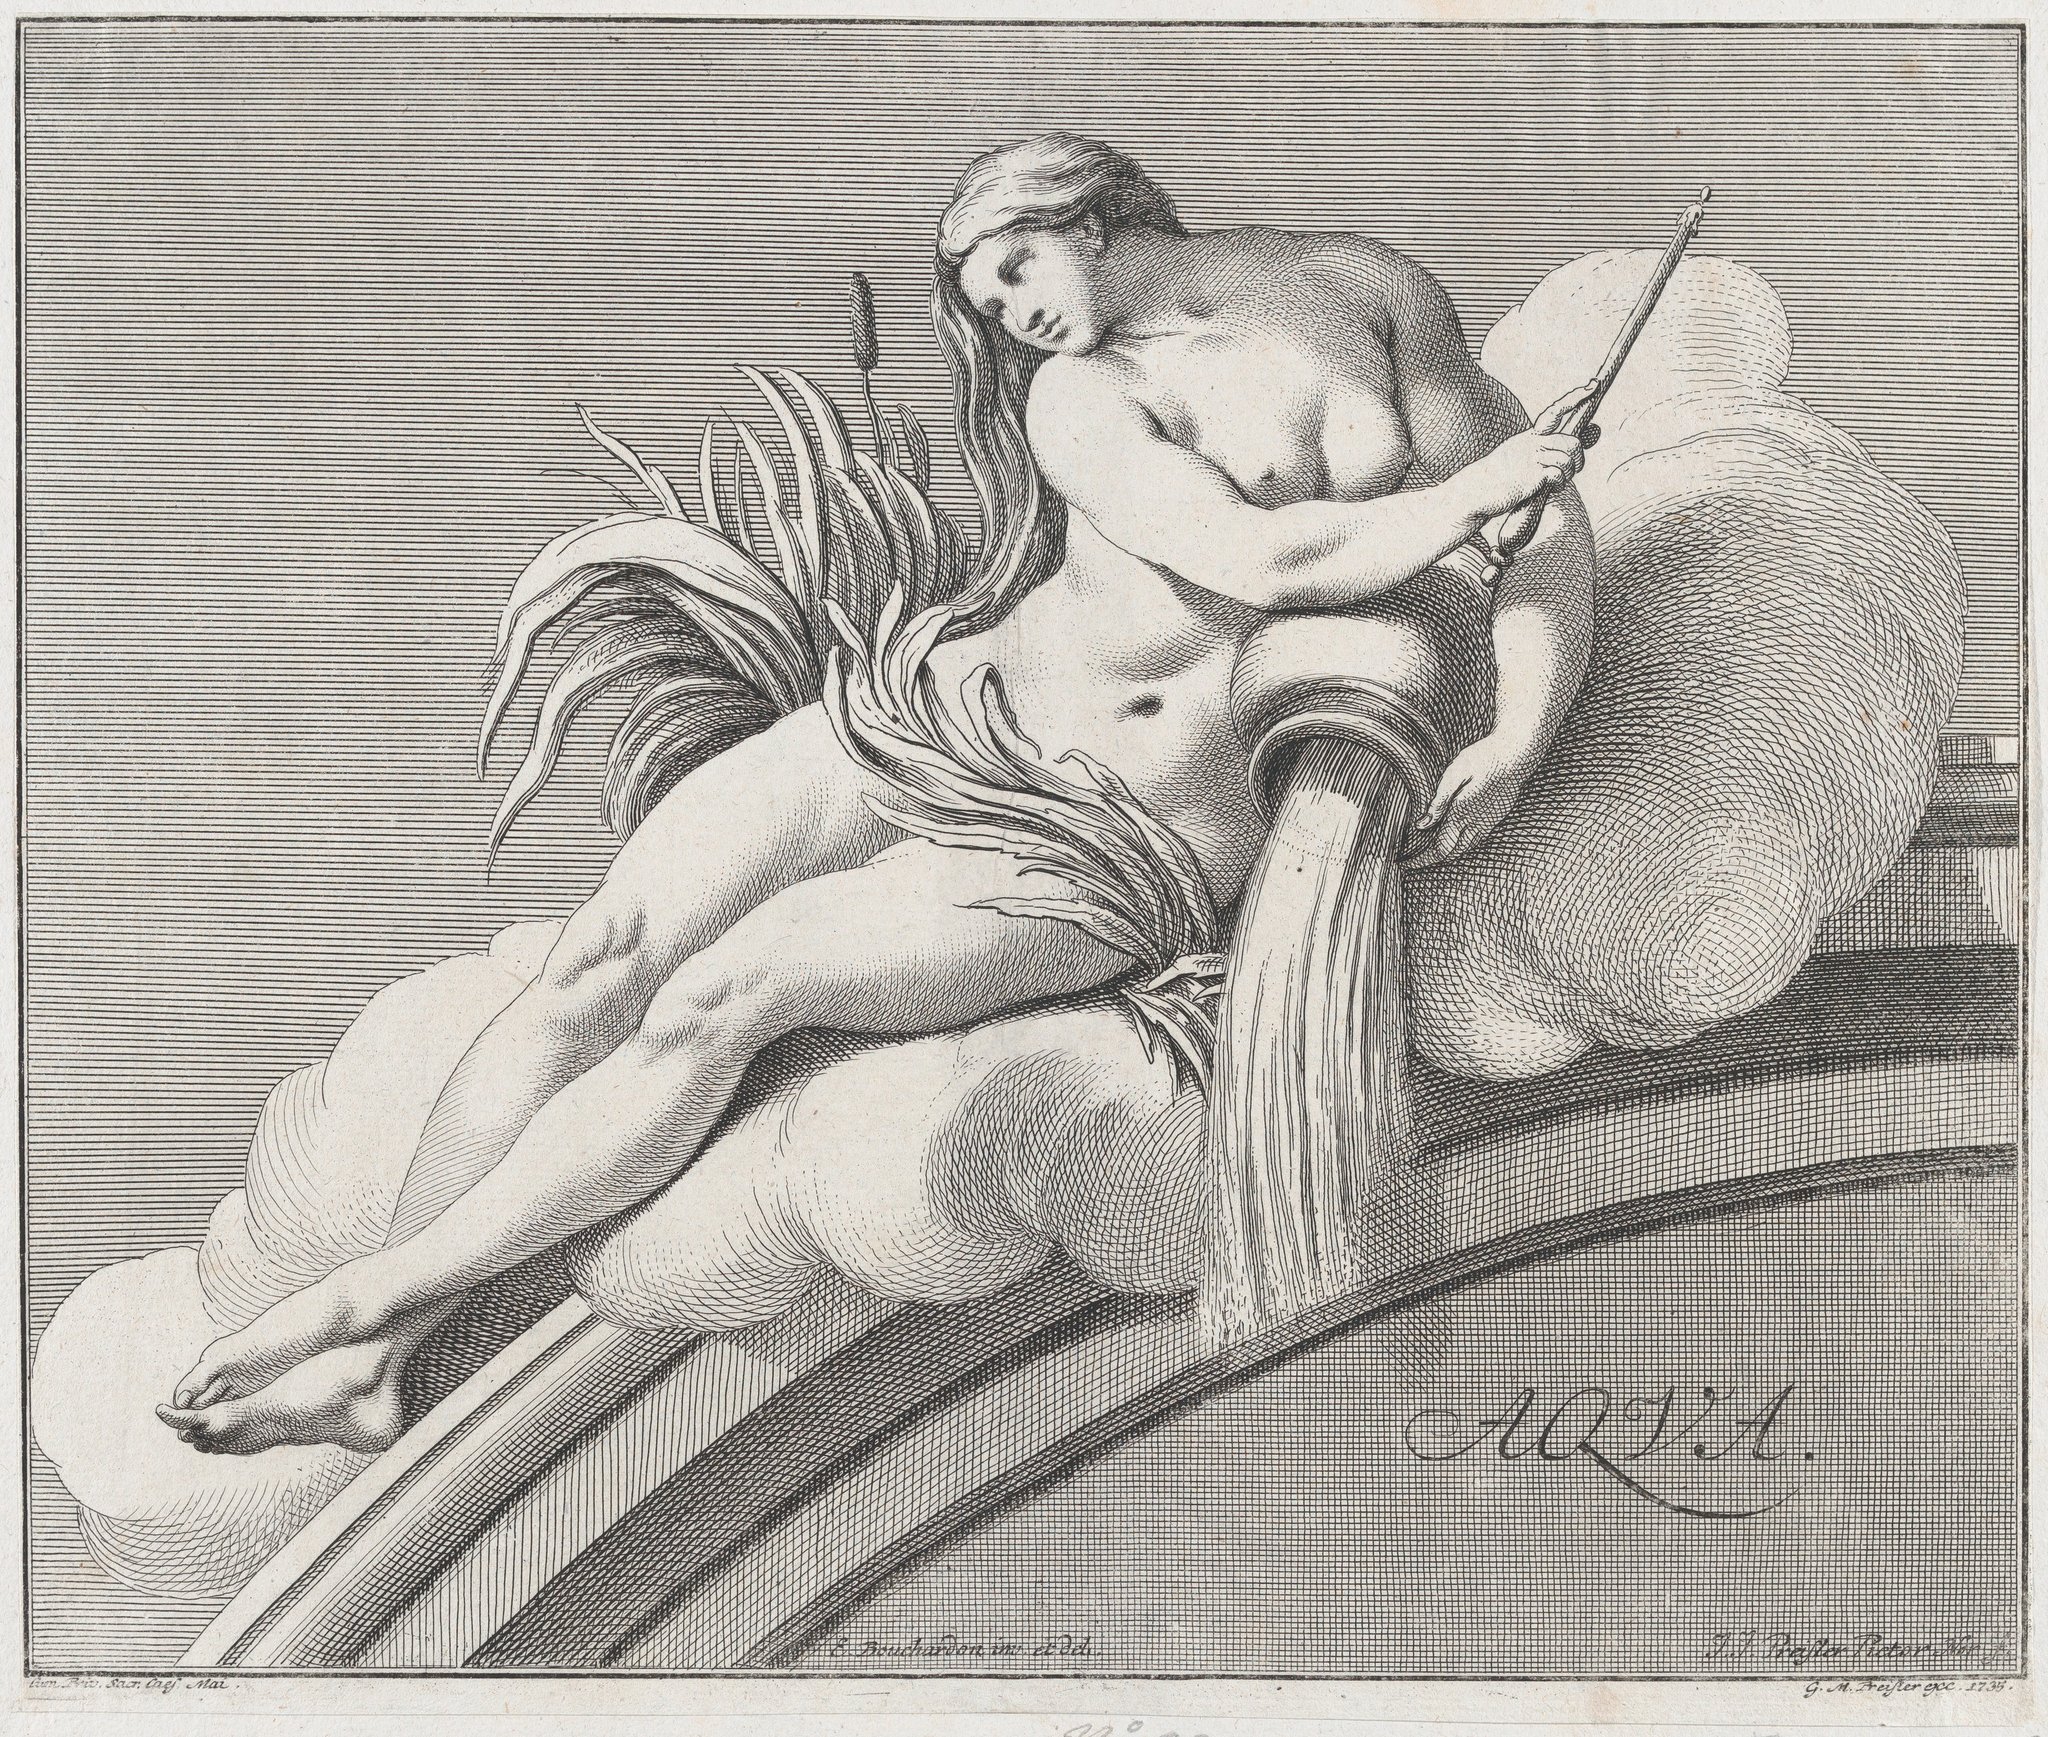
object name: print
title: Water, from "The Elements"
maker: johann justin preissler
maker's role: artist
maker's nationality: german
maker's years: 1698-1771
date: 1735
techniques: engraving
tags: female nudes